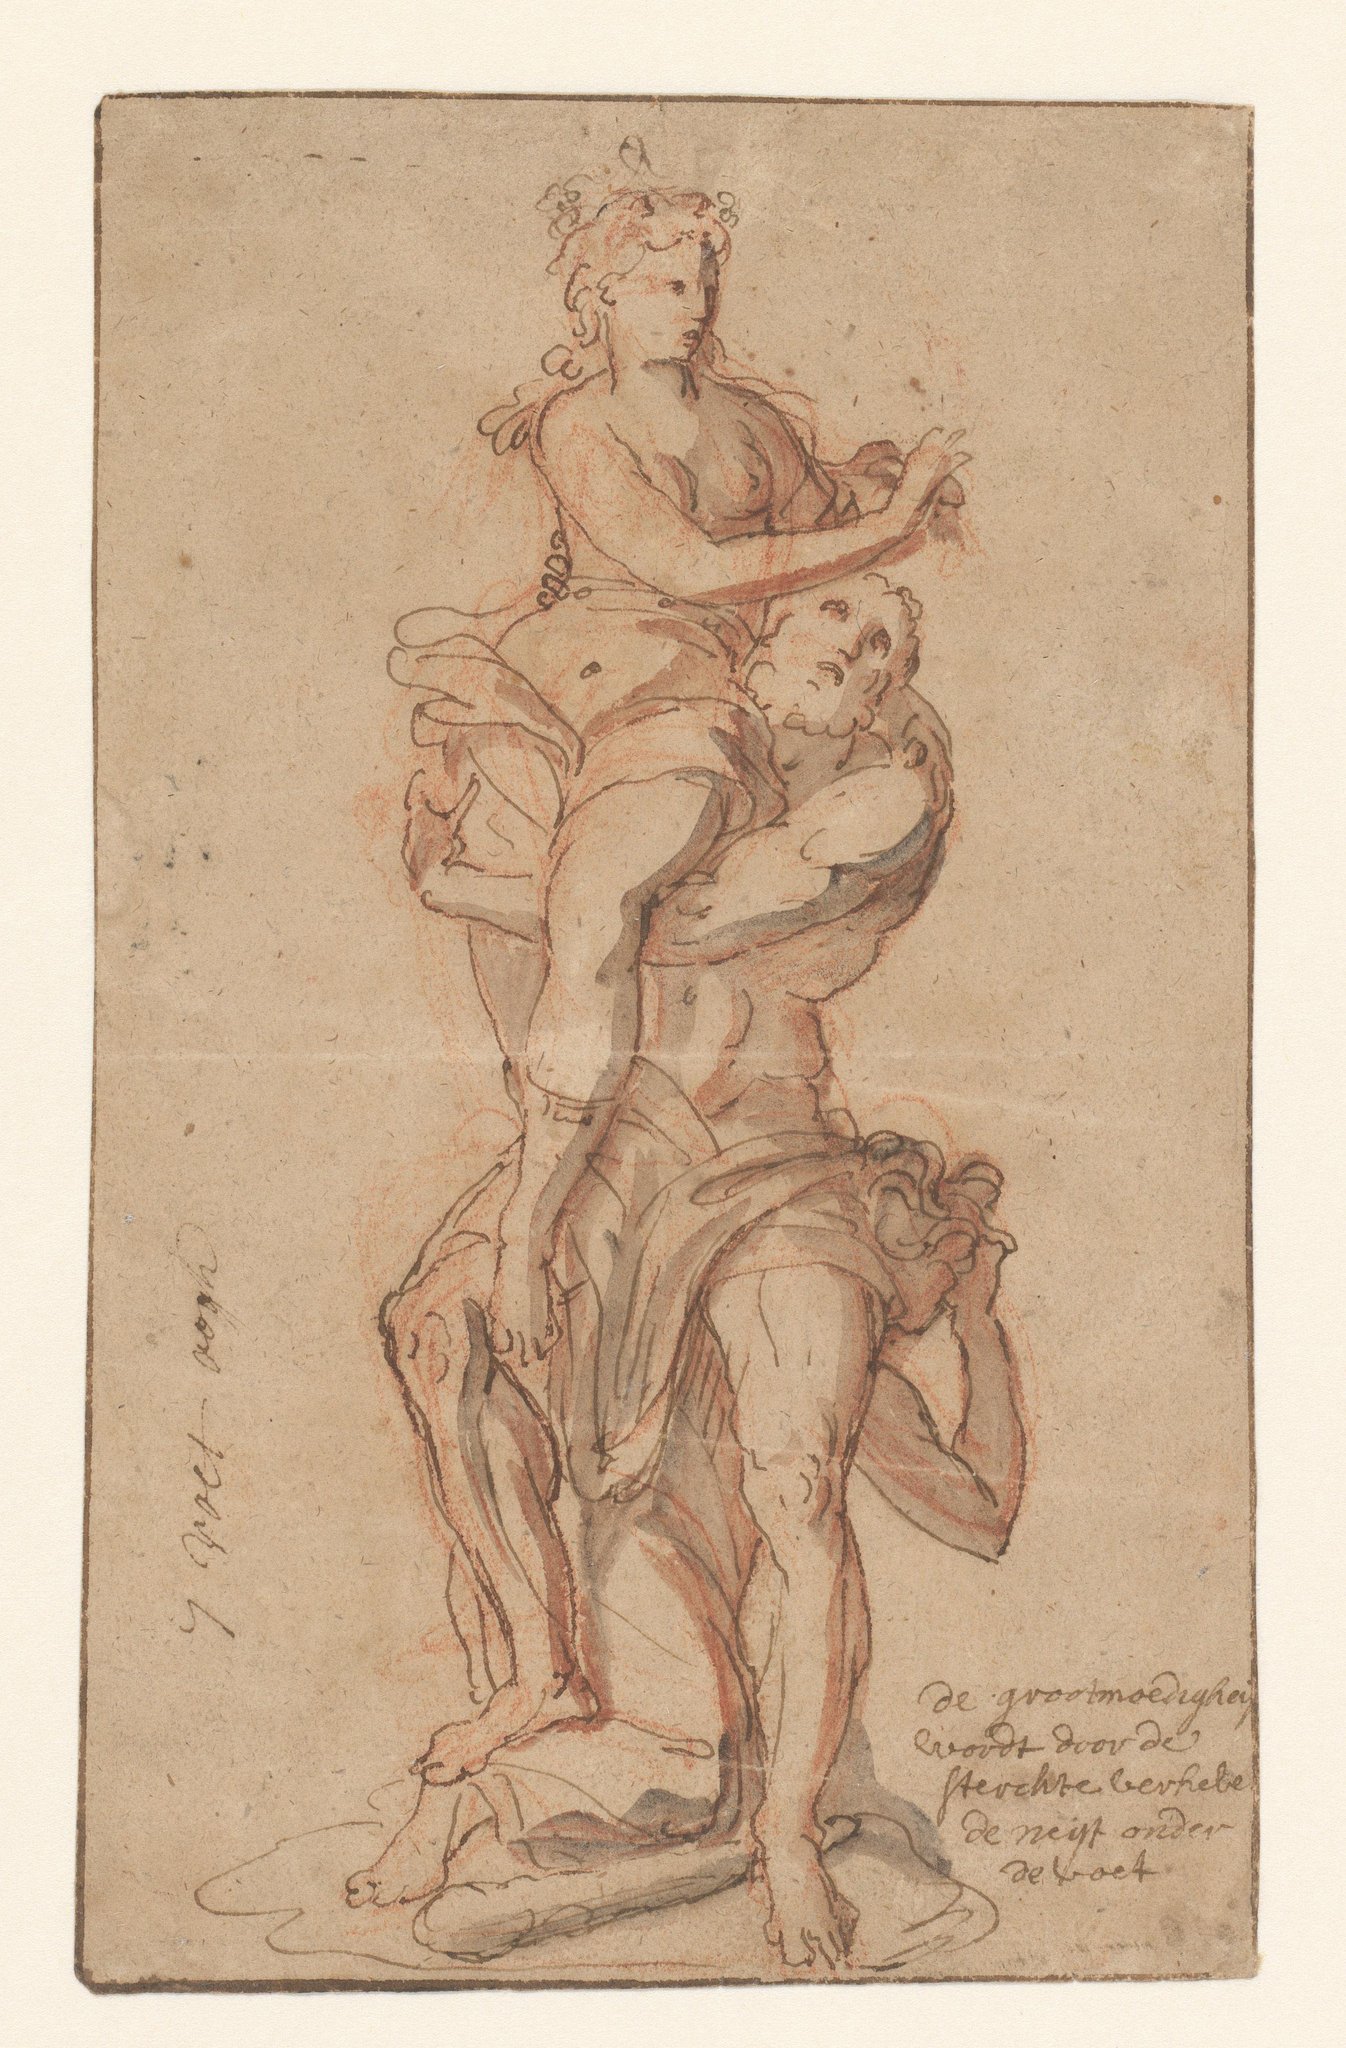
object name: design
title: Ontwerp voor een beeldengroep met de personificaties van Grootmoedigheid, Kracht en Afgunst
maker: Anonymous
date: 1600-1699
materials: chalk, ink, paper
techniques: brush, pen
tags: piece of sculpture, reproduction of a piece of sculpture, strength, power; 'fortezza', 'fortezza d'animo e di corpo', 'fortezza del corpo congiunta con la generosità dell'animo', 'fortezza & valore del corpo congiunto con la prudenza & virtù del animo', 'forza' (ripa), jealousy; 'gelosia', 'rammarico del ben'altrui' (ripa) (+ strife between concepts), magnanimity; 'grandezza e robustezza d'animo', 'magnanimità' (ripa) (+ one concept conquering the other)